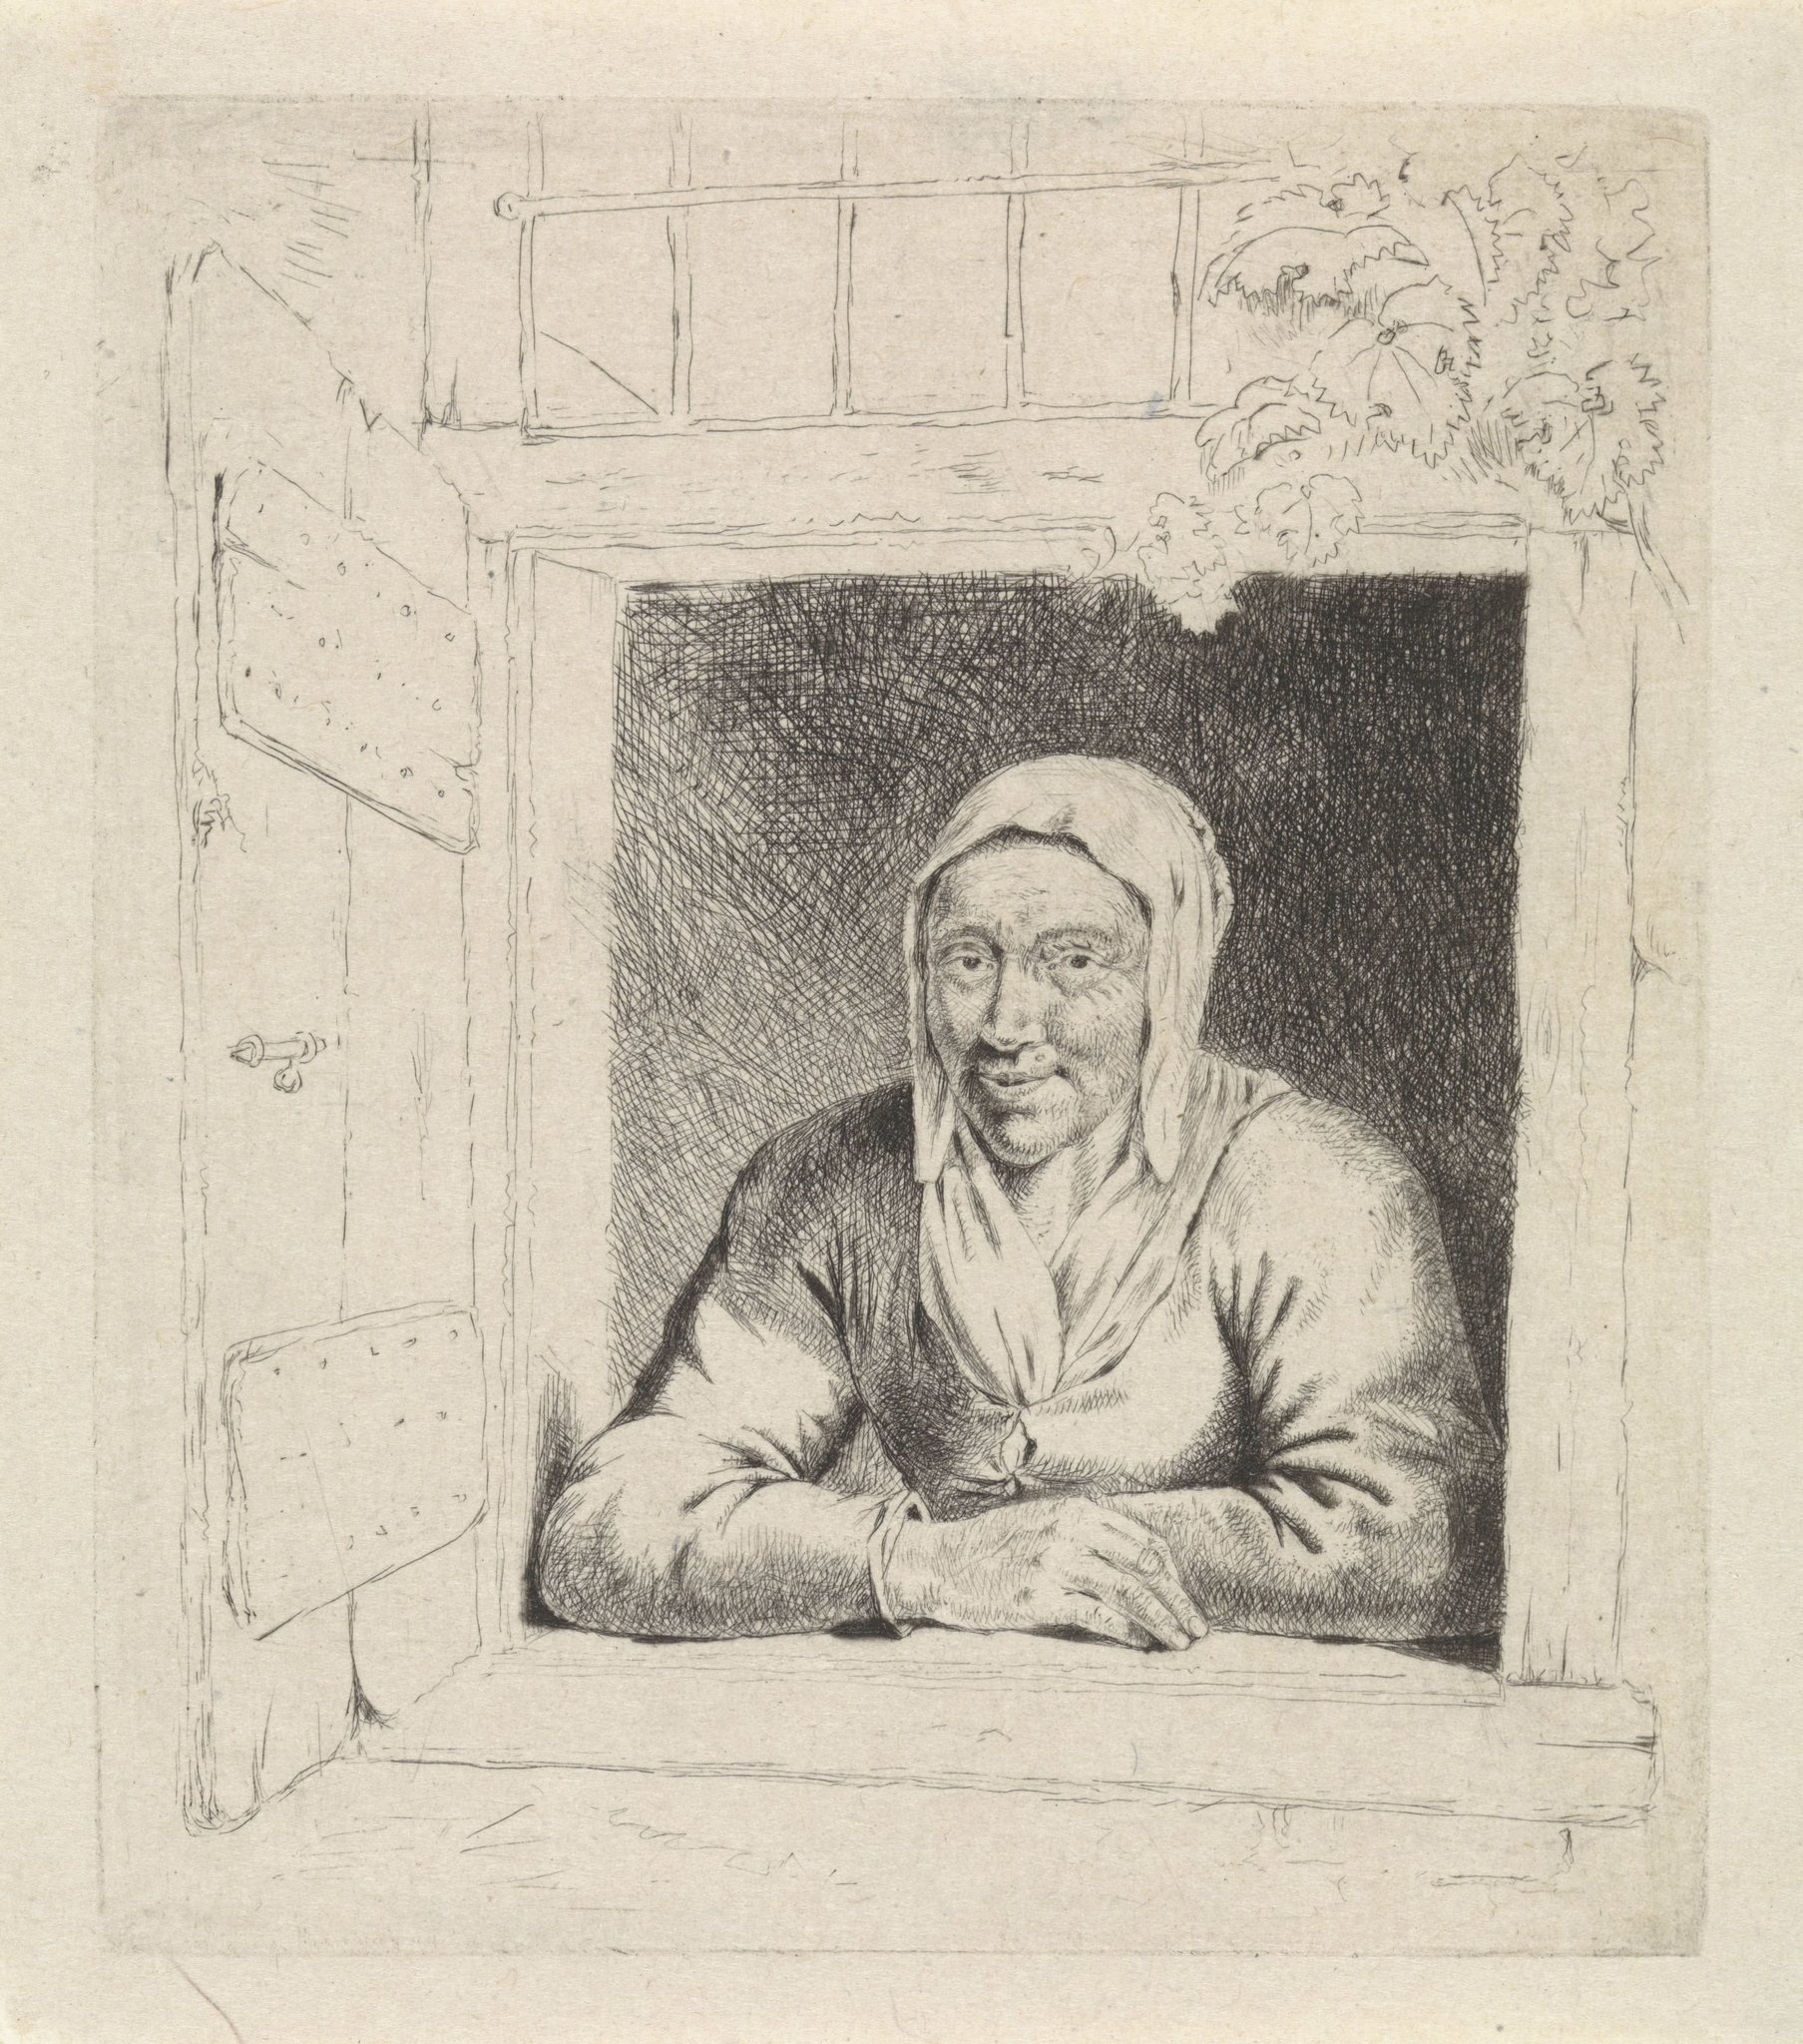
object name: print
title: Vrouw in venster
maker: johannes christiaan janson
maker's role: draughtsman, painter, print maker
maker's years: 1763-1823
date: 1778-1823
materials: paper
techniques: etching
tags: human figure at (open) window, seen from outside - aa - feigned window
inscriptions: collector's mark: Lugt 240